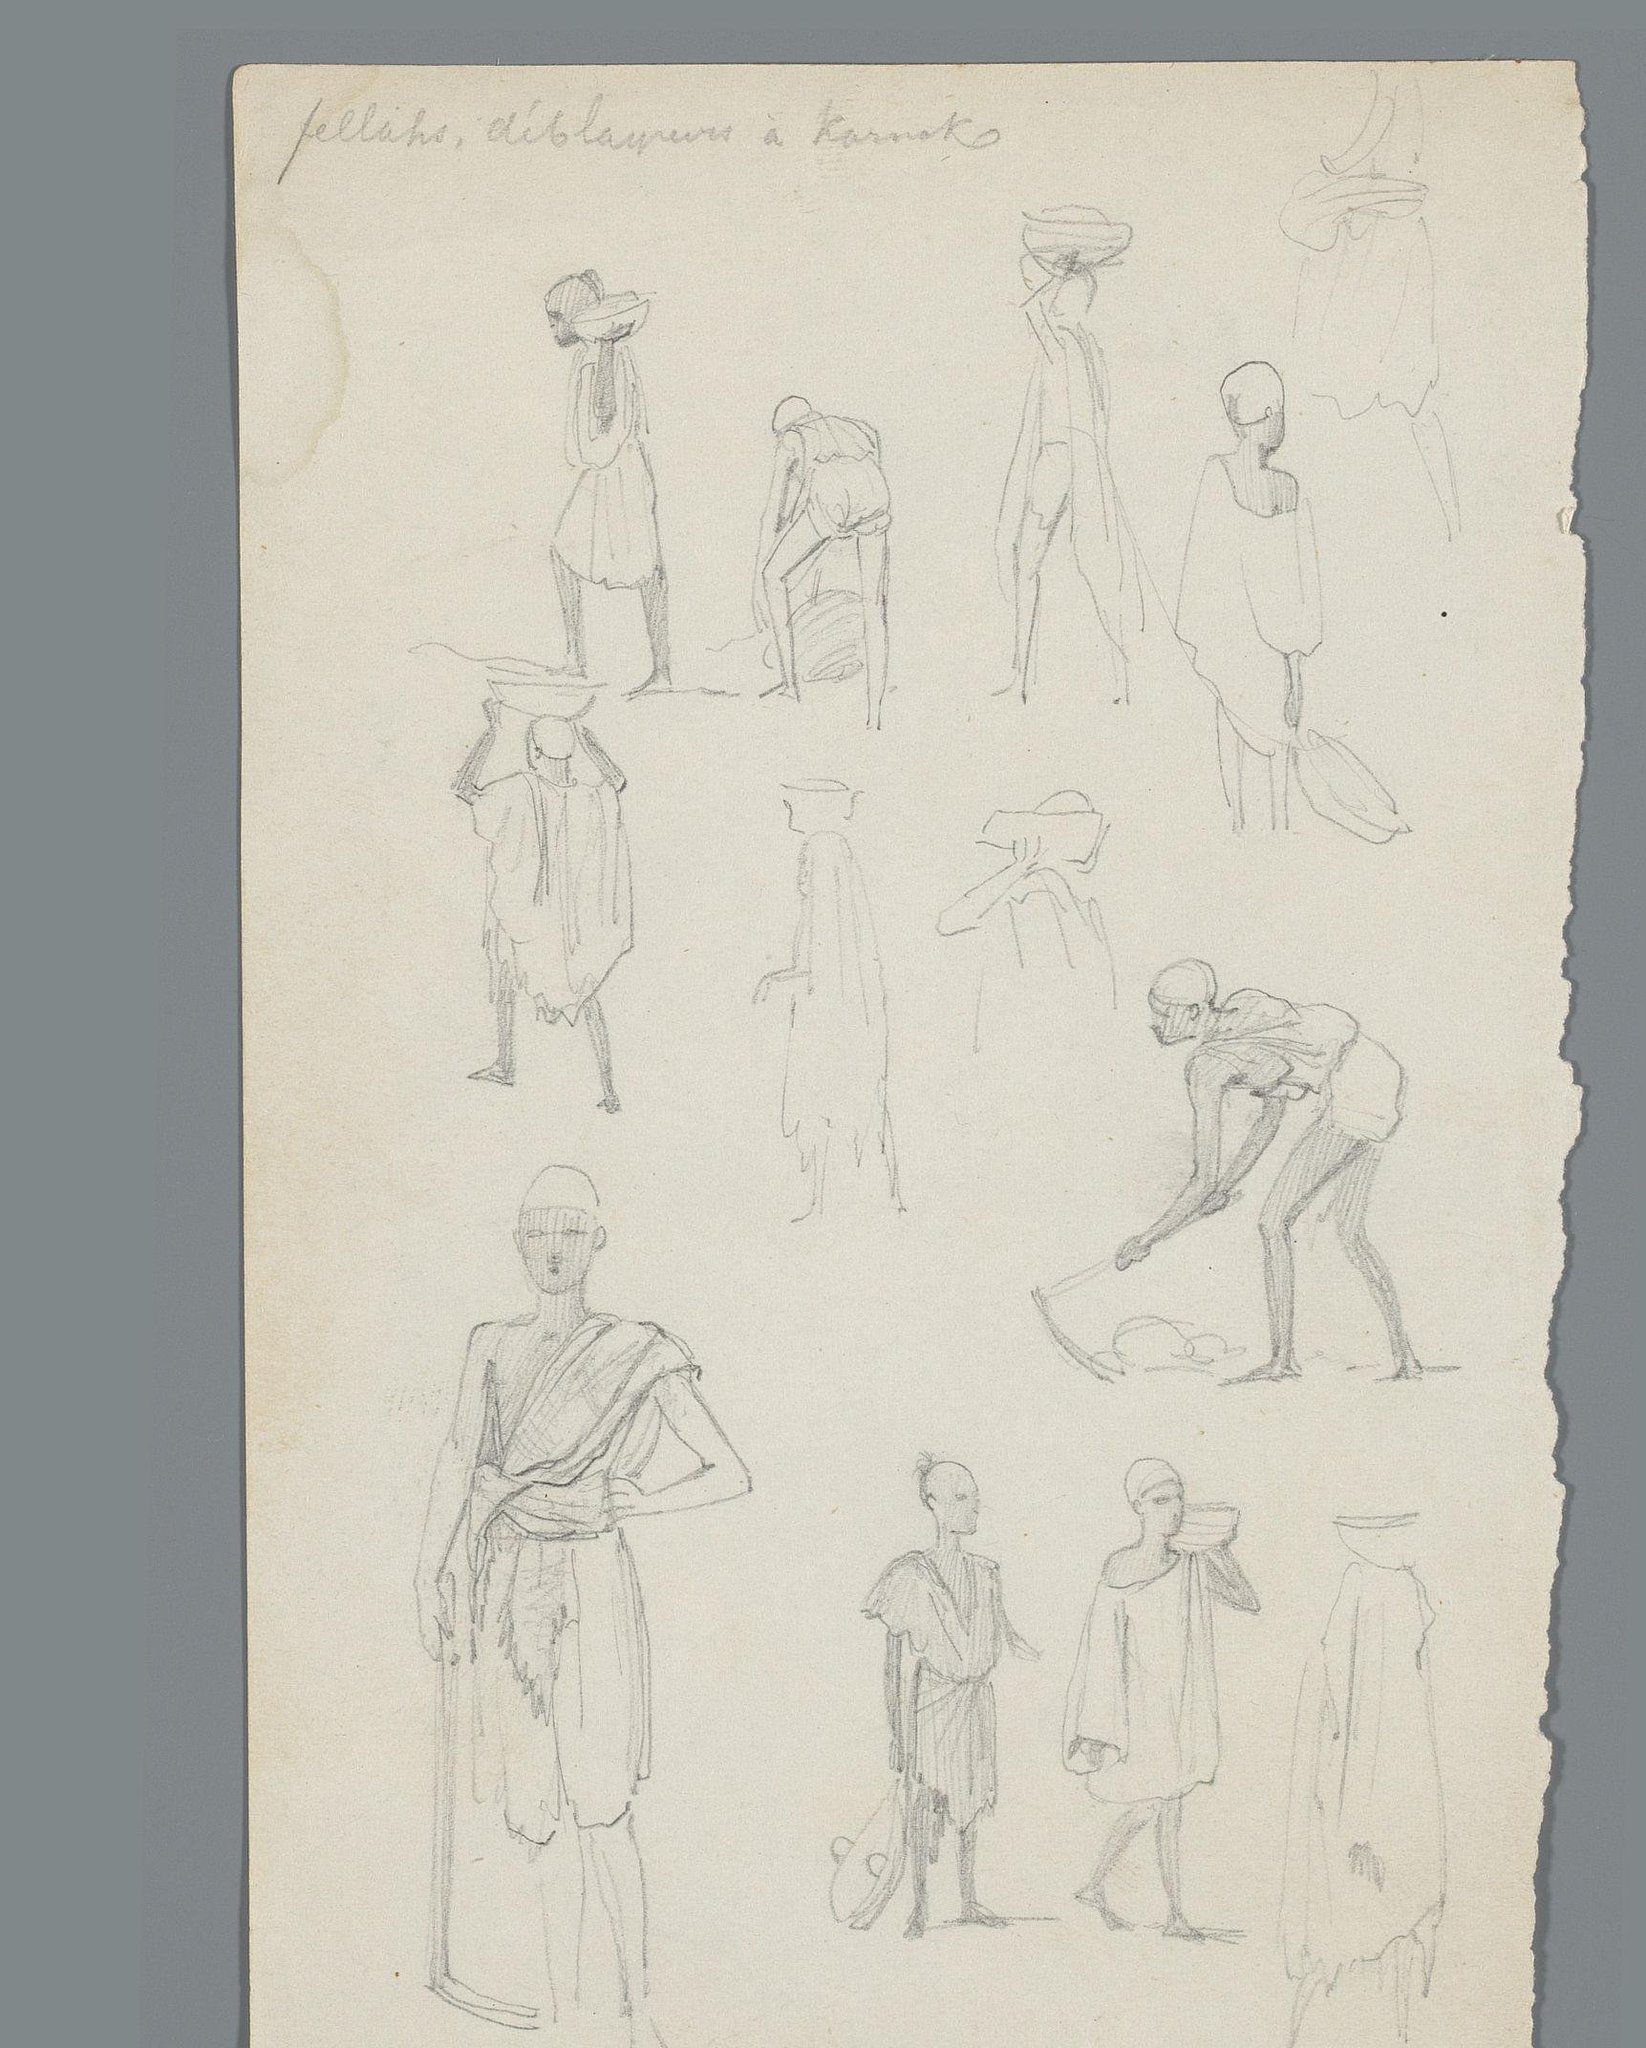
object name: sketchbook leaf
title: Compositie met Egyptische arbeiders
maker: willem de famars testas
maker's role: draughtsman, painter, print maker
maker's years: 1834-1896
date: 1858-1859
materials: paper, pencil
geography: egypt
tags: standing figure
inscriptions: inscription: ‘fellahs, déblayeurs à Karnak’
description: Onderdeel van 20 losse bladen met tekeningen gemaakt tijdens Famars Testas zijn Egyptische reis van 1858, met voornamelijk figuren en dorpsgezichten met notities.